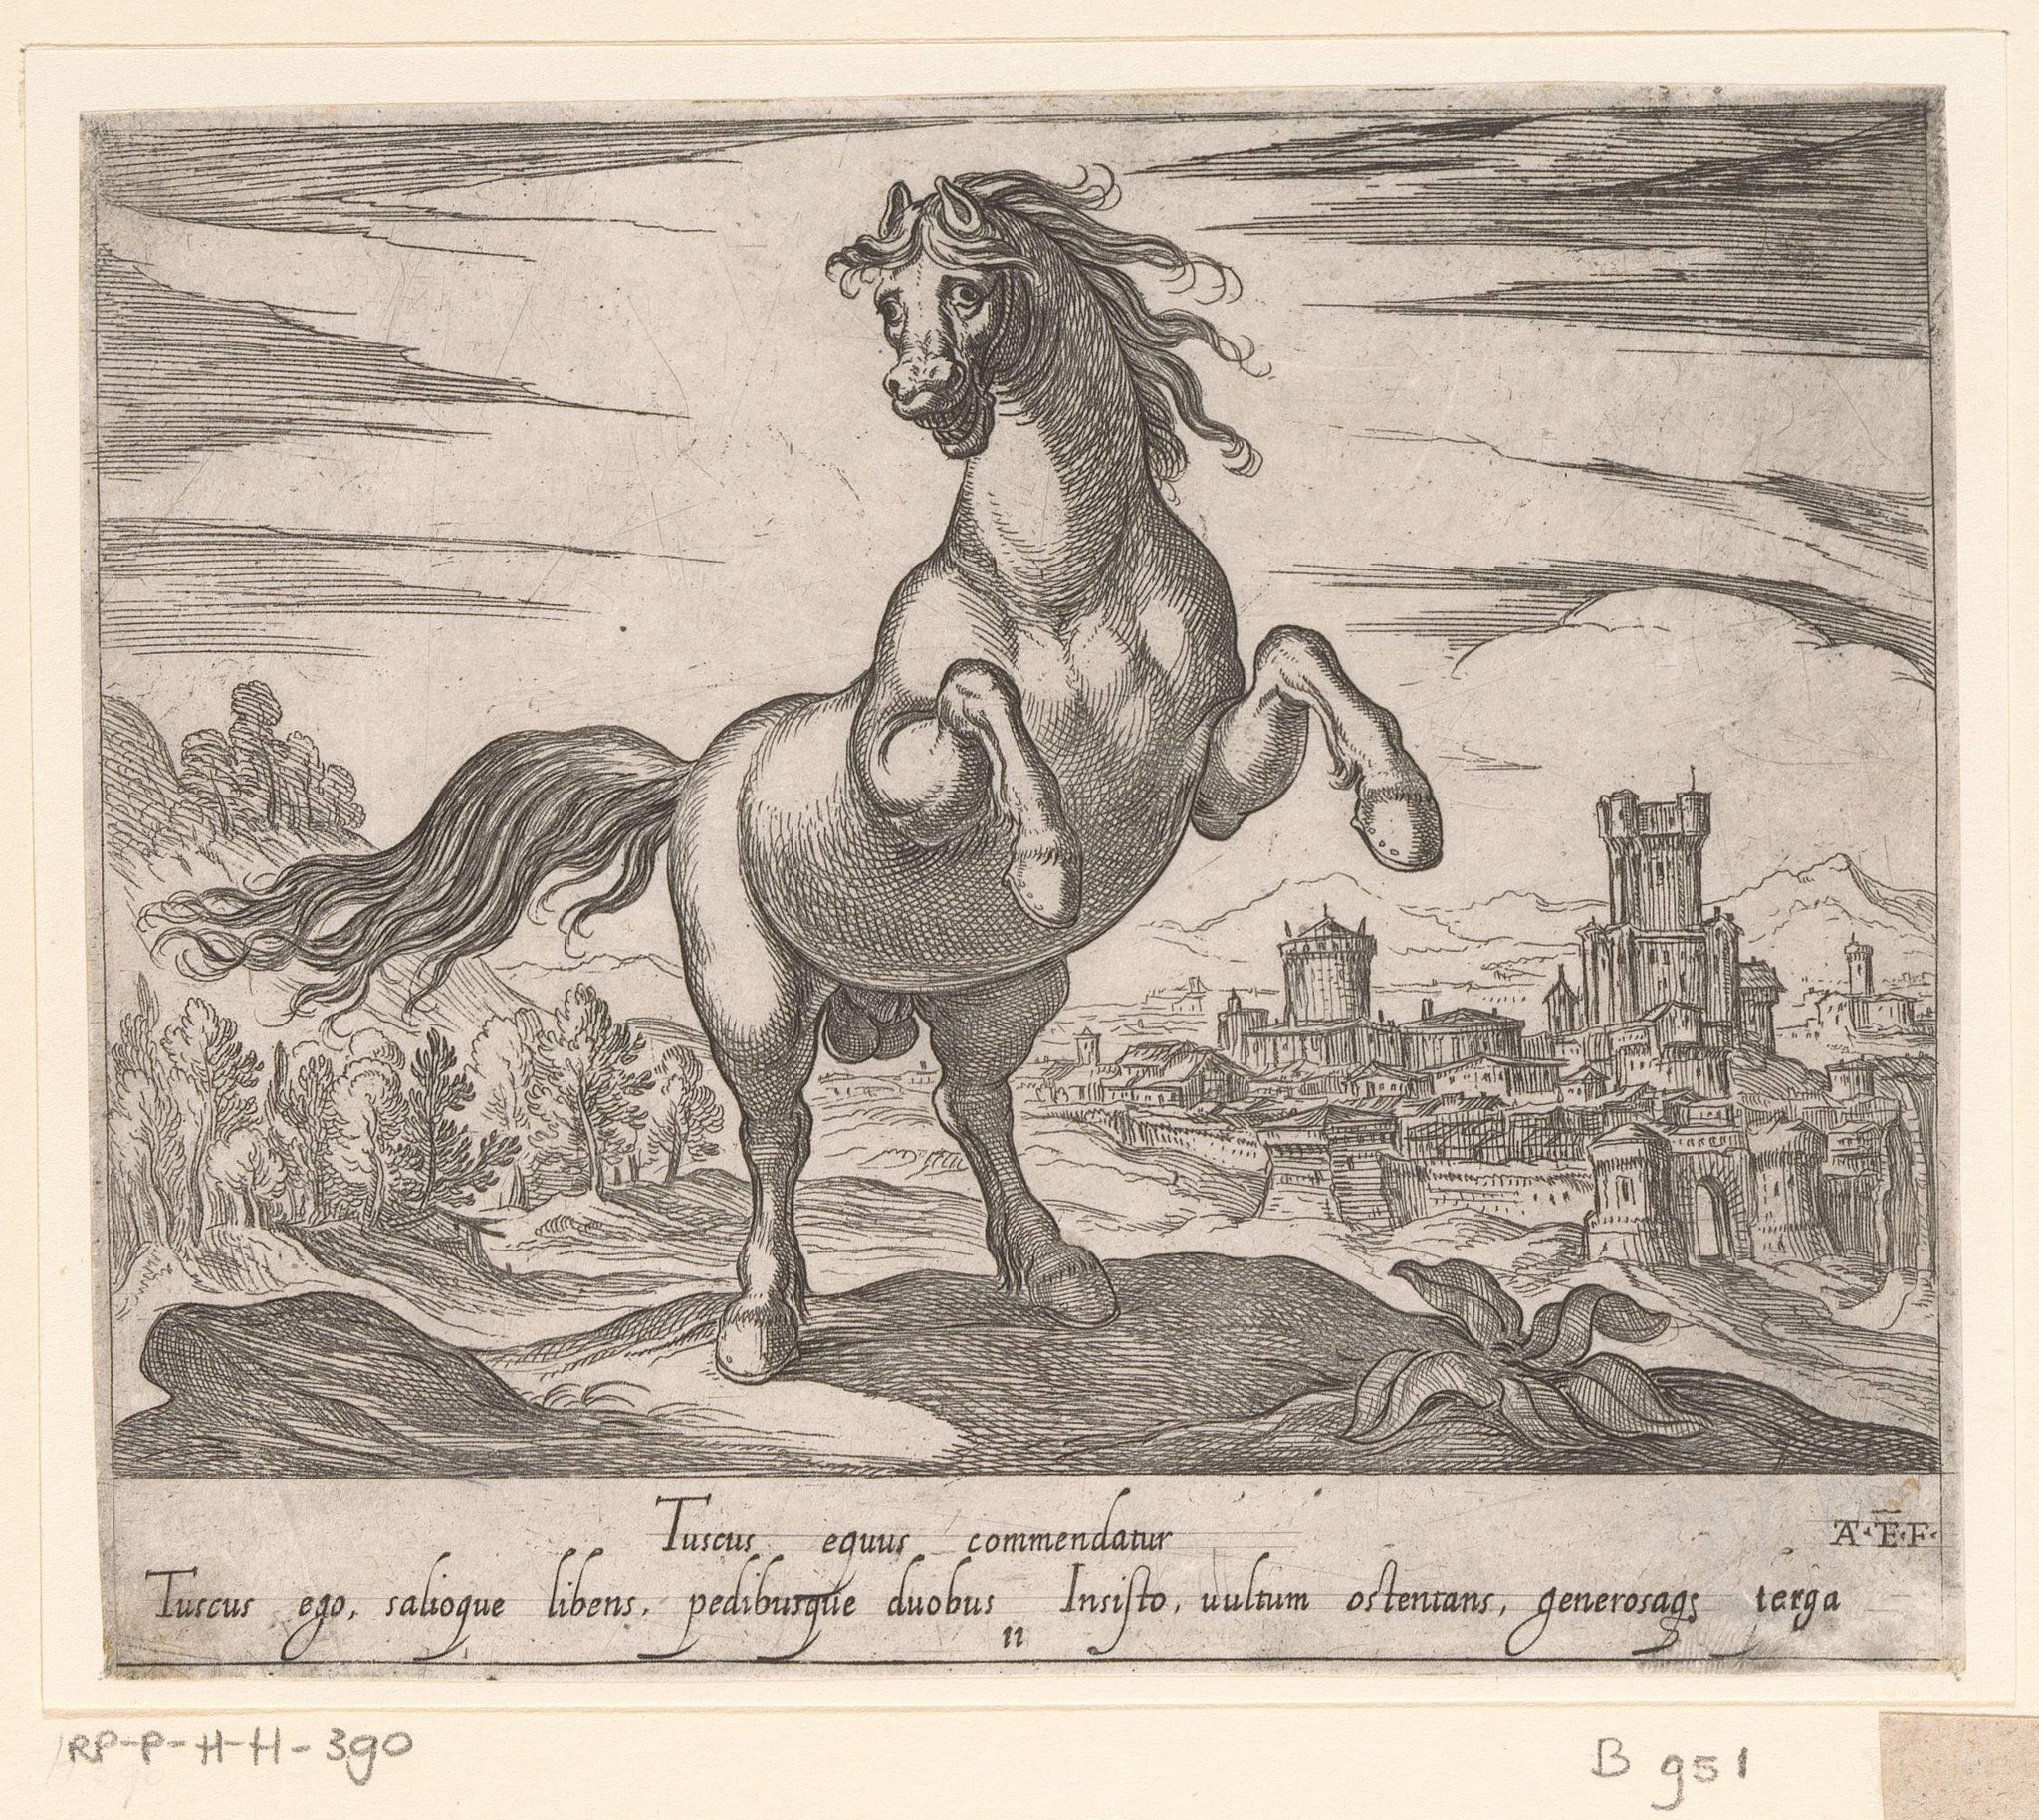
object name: print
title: Steigerend paard van voren gezien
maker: antonio tempesta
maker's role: draughtsman, painter, print maker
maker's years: 1555-1630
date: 1590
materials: paper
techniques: etching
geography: italy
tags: horse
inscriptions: number: ‘5’, collector's mark: ‘Hinloopen’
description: Deze prent maakt deel uit van een reeks van 28 prenten van paarden (+ titelprent en opdracht).